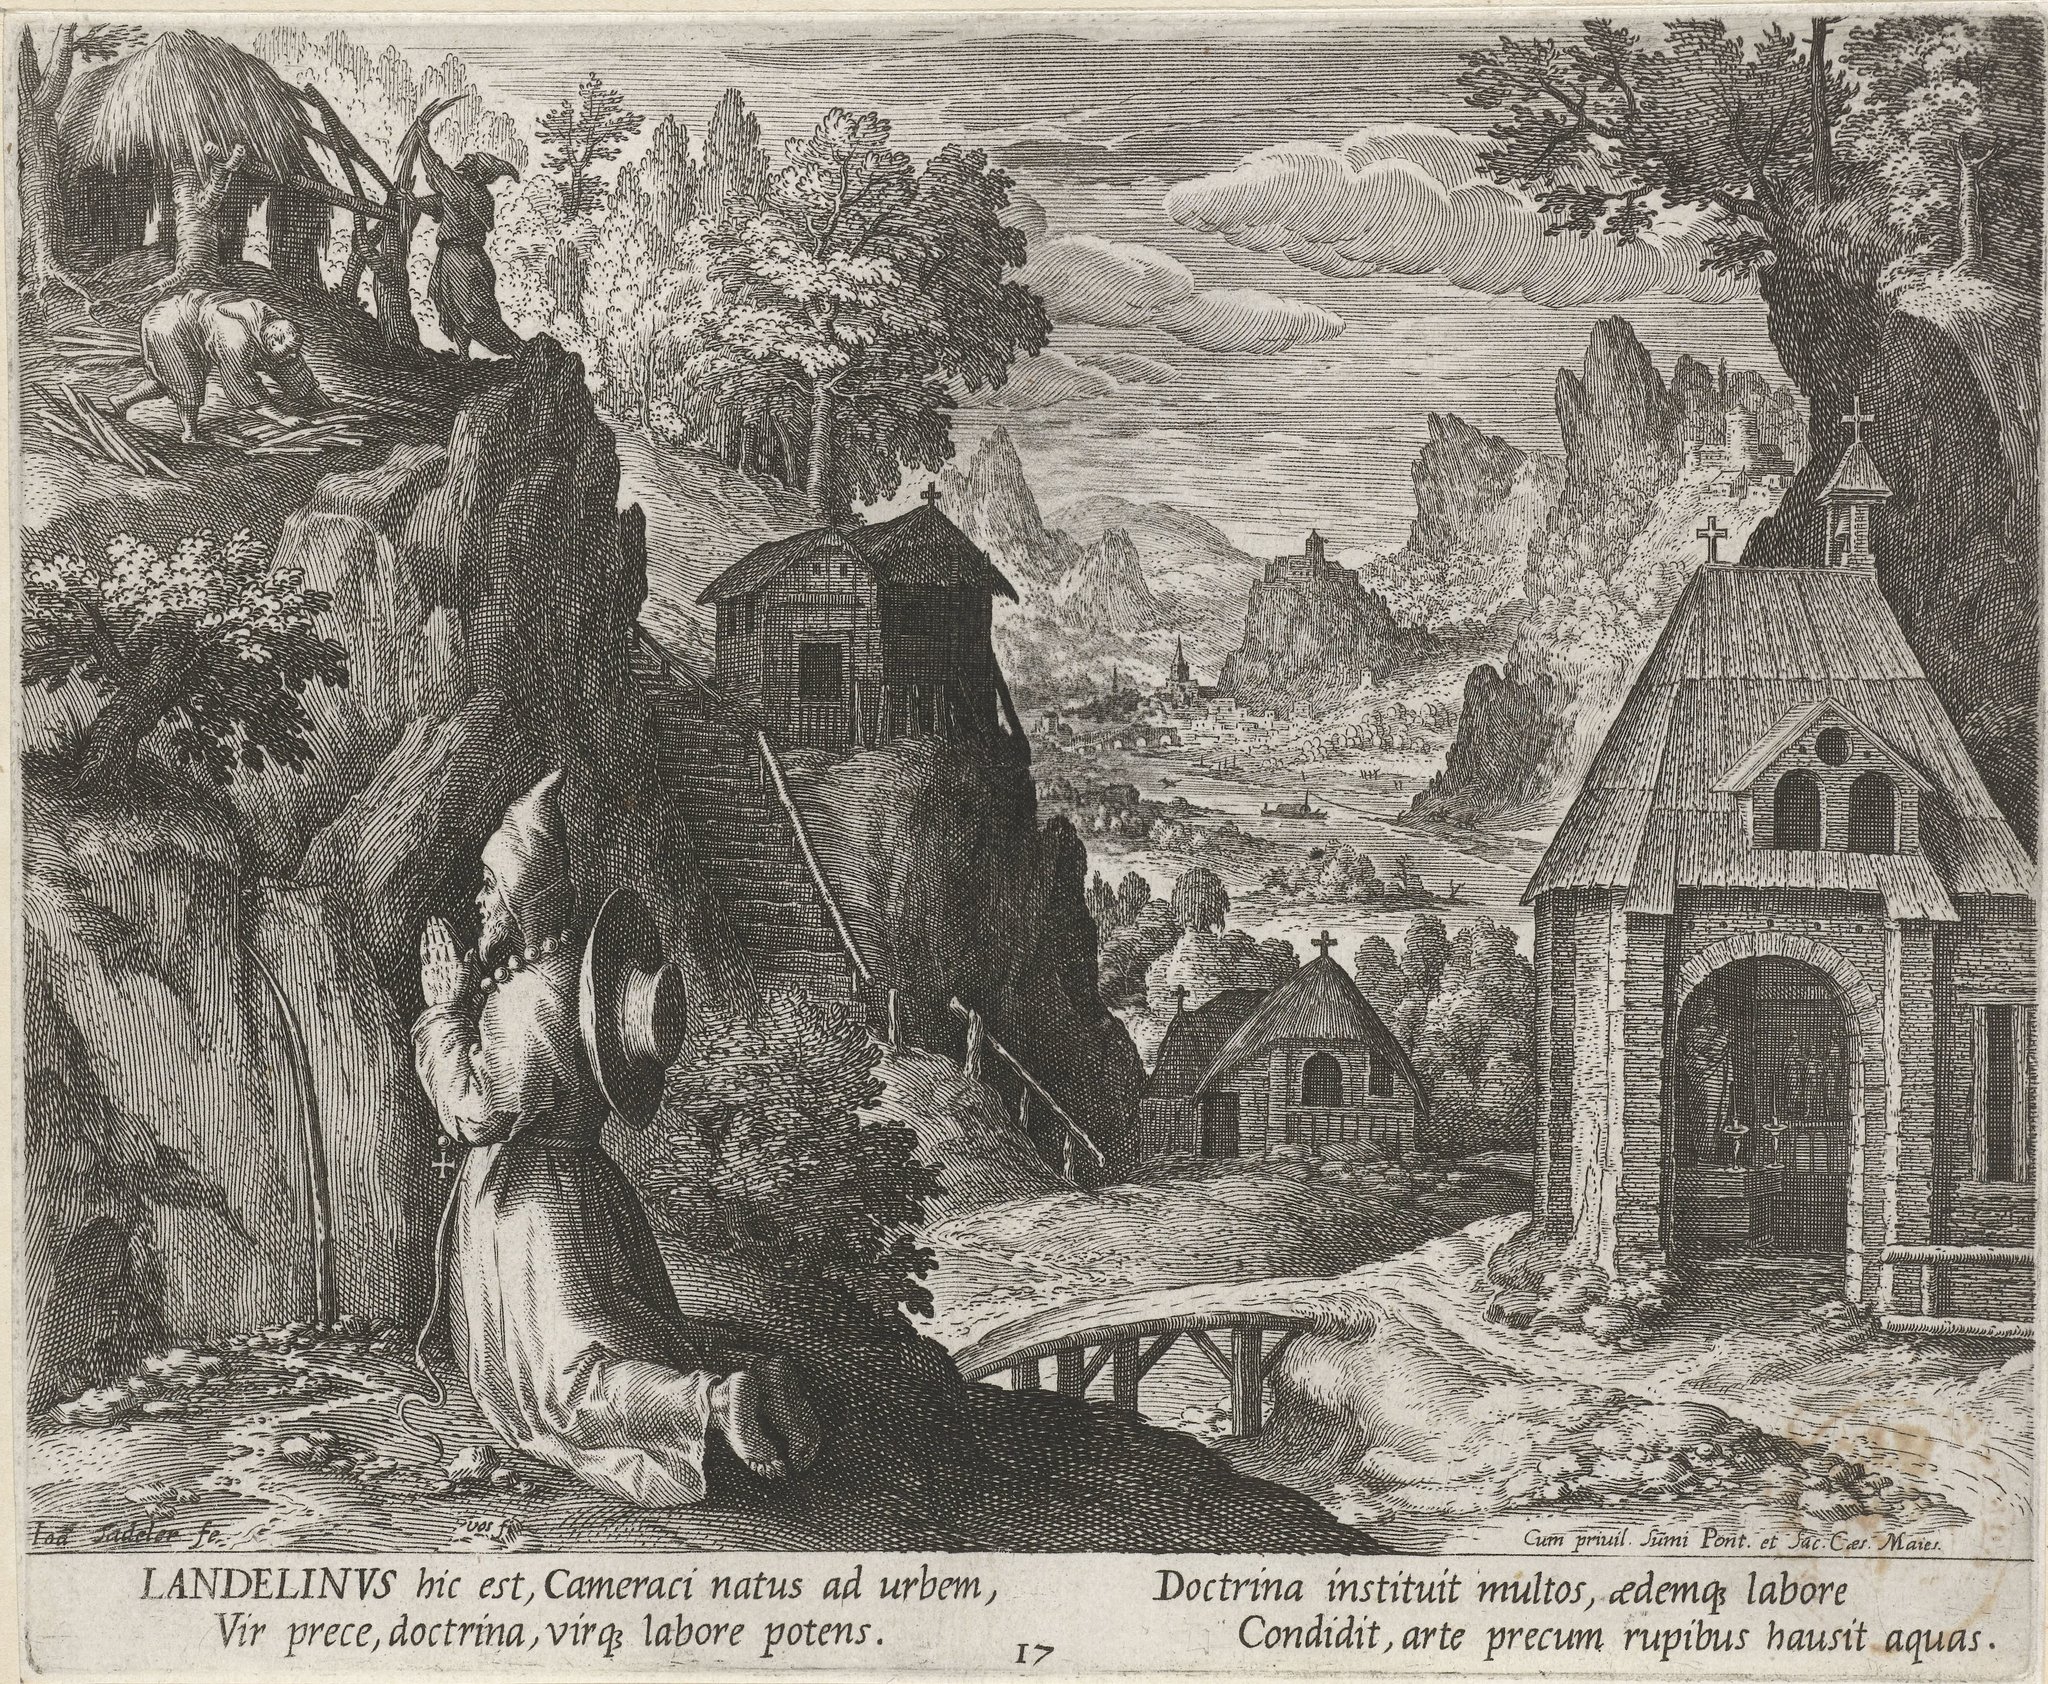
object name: print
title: Oraculum Anachoreticum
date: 1600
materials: paper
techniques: engraving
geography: venice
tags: (high) hill, anchorite, hermit, spring, source of river or stream, male saints (with name)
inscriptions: collector's mark: Lugt 240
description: Een berglandschap. Op de voorgrond de H. Landelinus van Lobbes, een Waalse kluizenaar uit de zevende eeuw na Christus. Hij zit op zijn knieën te bidden voor een rots waar een bron ontspringt. Op de achtergrond enkele hutjes van kluizenaars.